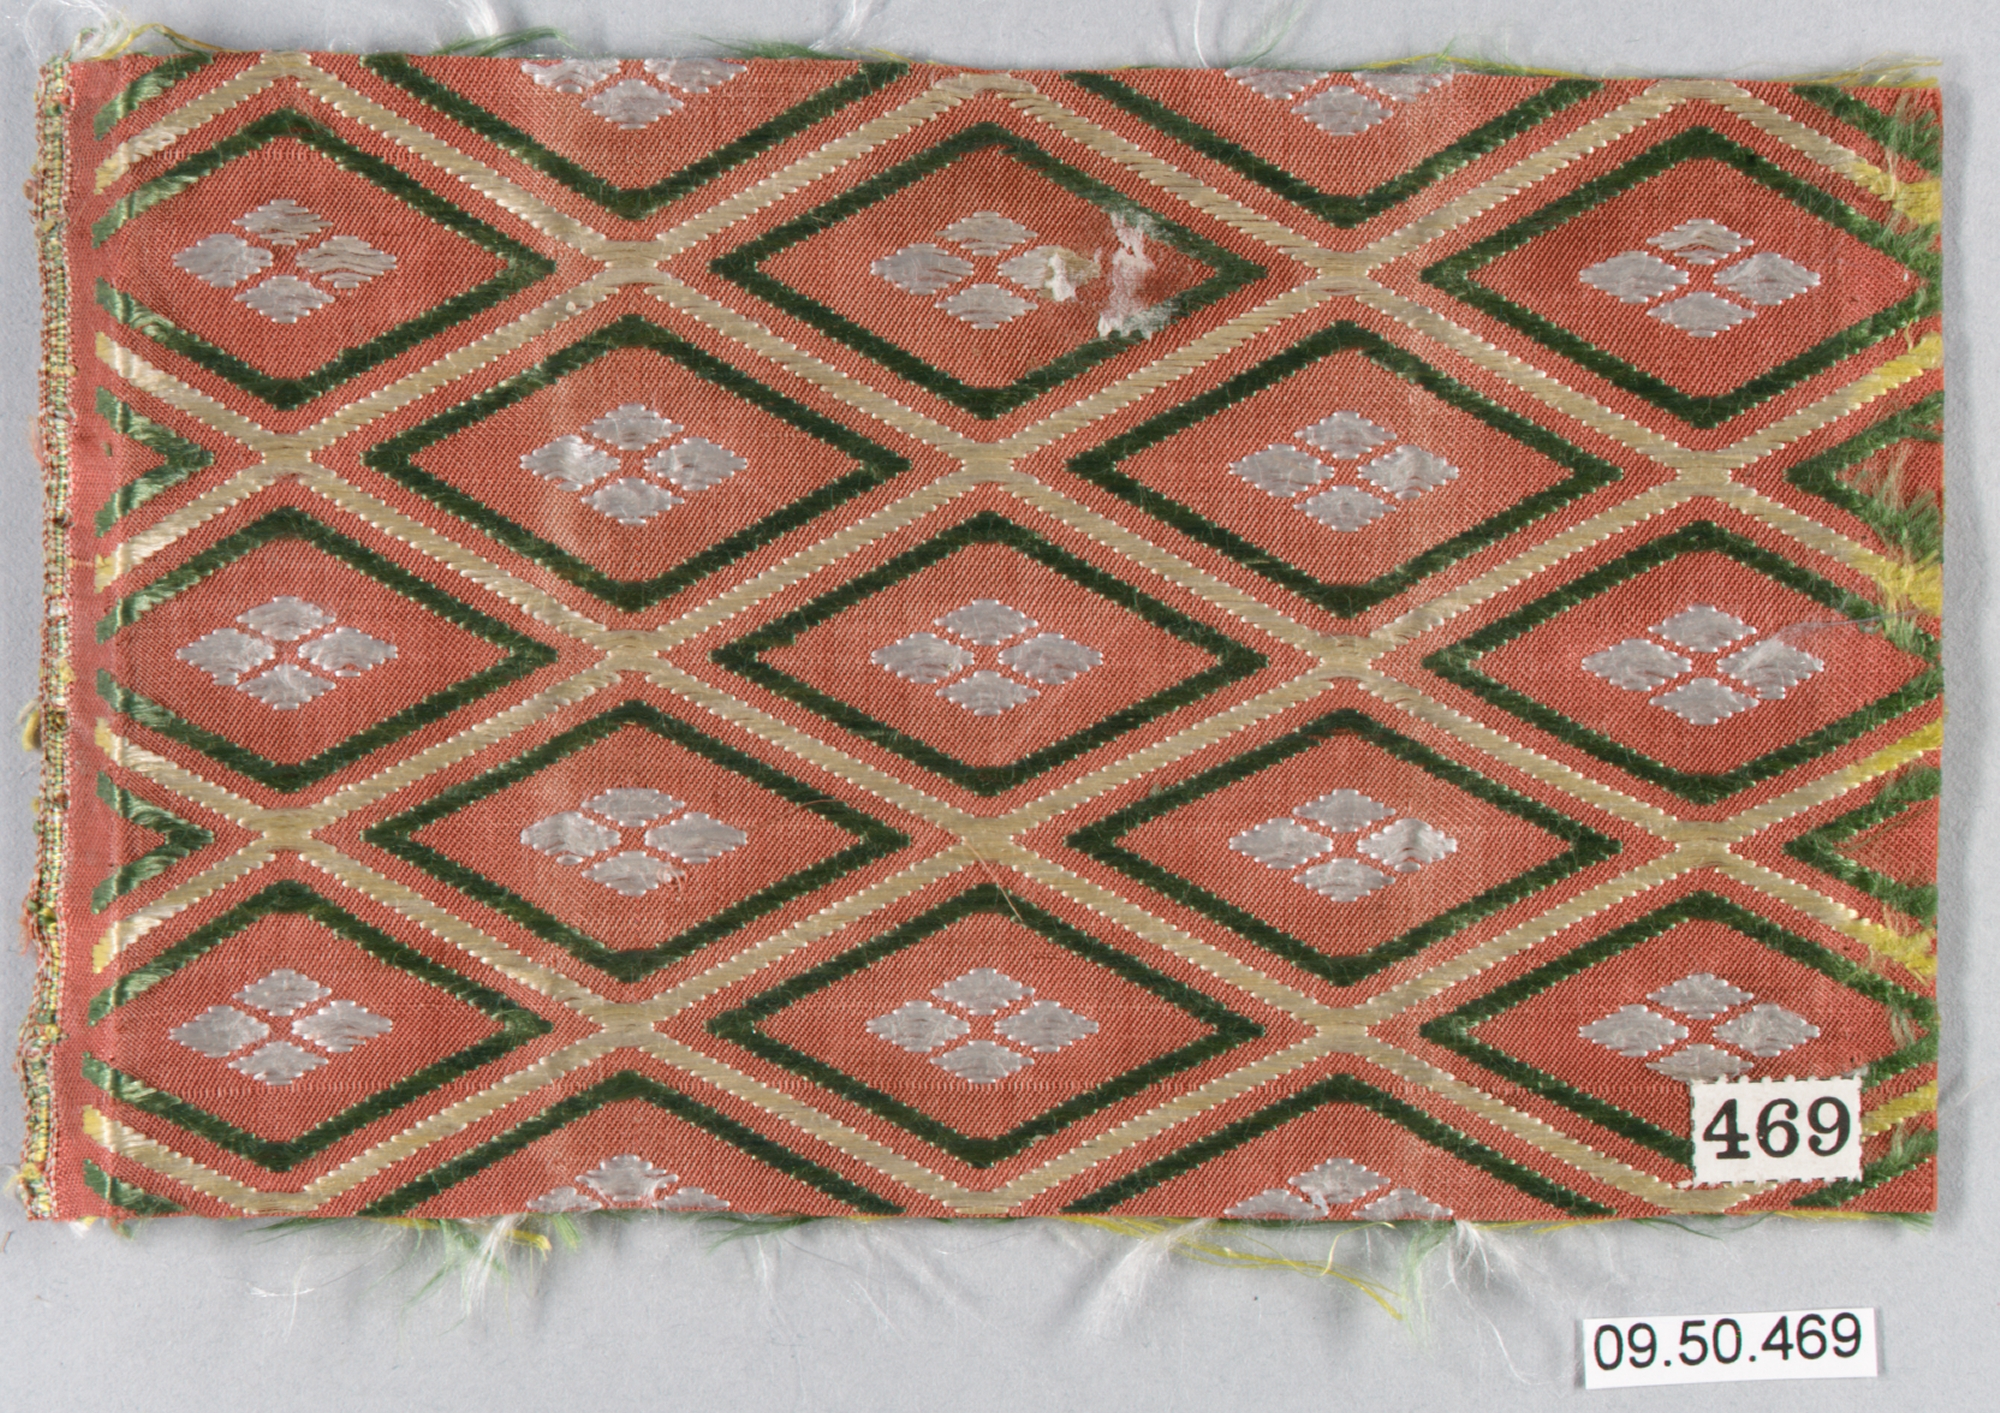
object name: piece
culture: japanese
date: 1667-1733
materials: silk